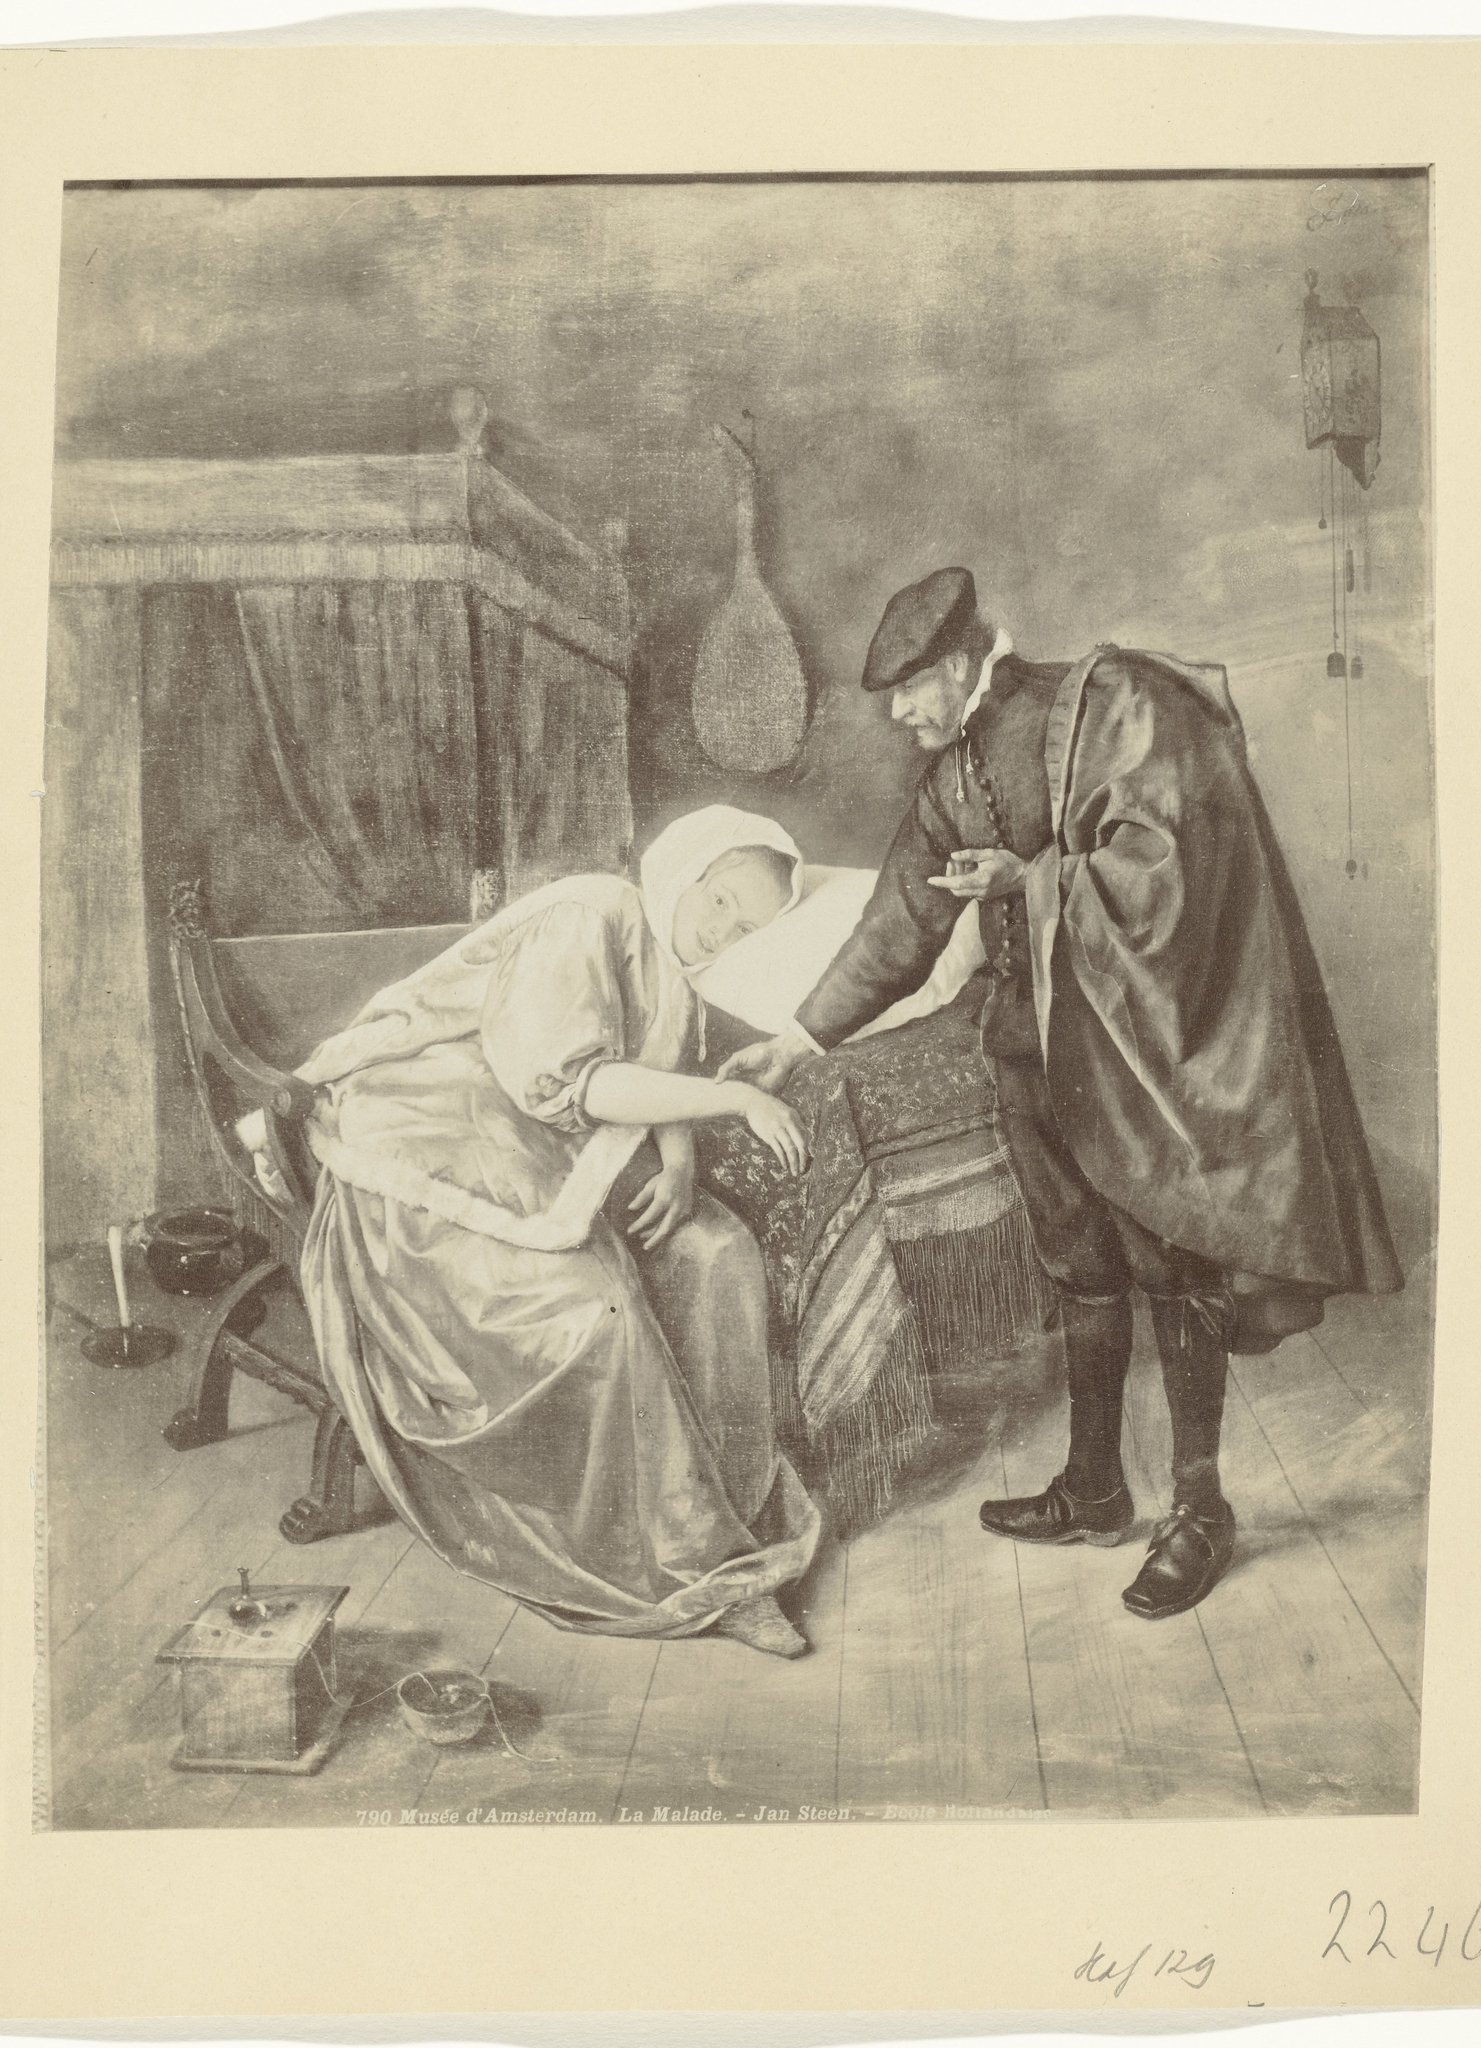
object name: photograph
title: Musée d'Amsterdam. La Malade. - Jan van Steen. - Ecole hollandaise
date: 1867-1880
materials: cardboard, paper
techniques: albumen print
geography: amsterdam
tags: physician, doctor, patient, sick person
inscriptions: inscription: ‘790 Musée d'Amsterdam. La Malade. - Jan Steen. - Ecole Hollandaise’, inscription: ‘Hdf 129 2246’, collector's mark: Lugt 2228